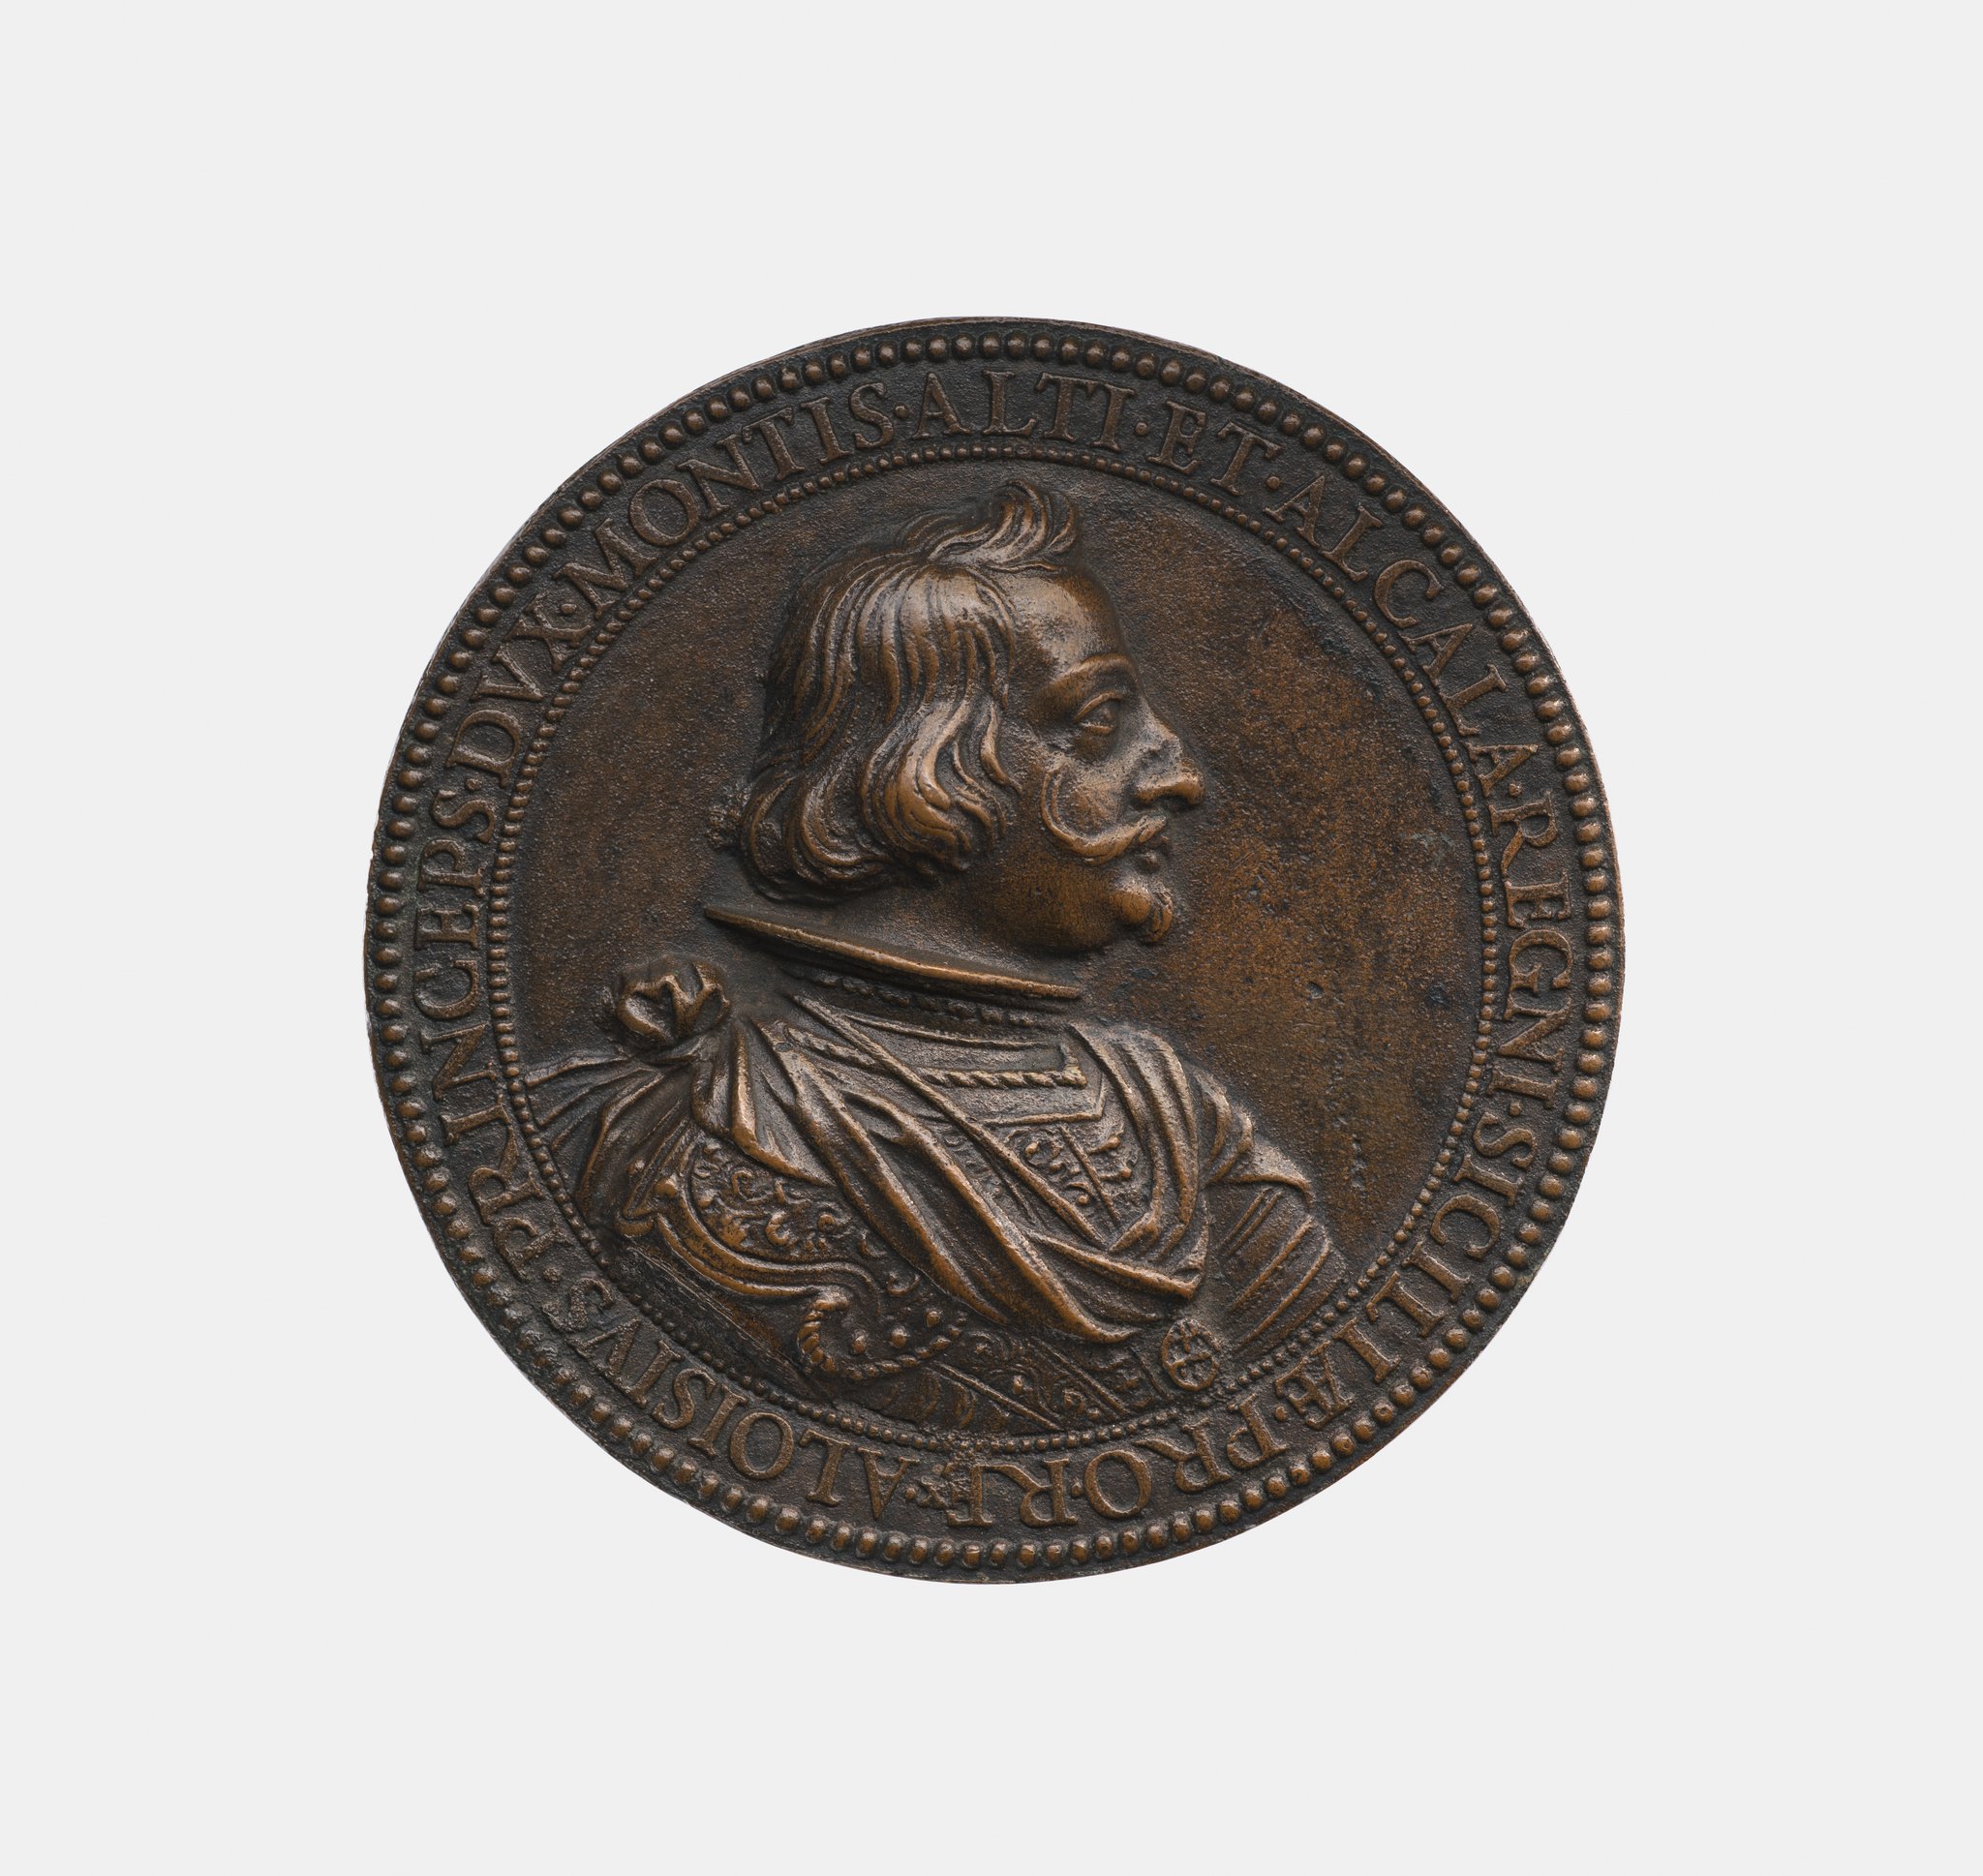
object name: uniface medal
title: Alvise, Duke of Montalto and Alcala, Governor of Sicily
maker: m. pirix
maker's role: artist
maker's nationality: spanish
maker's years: 1600-1650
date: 1638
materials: bronze